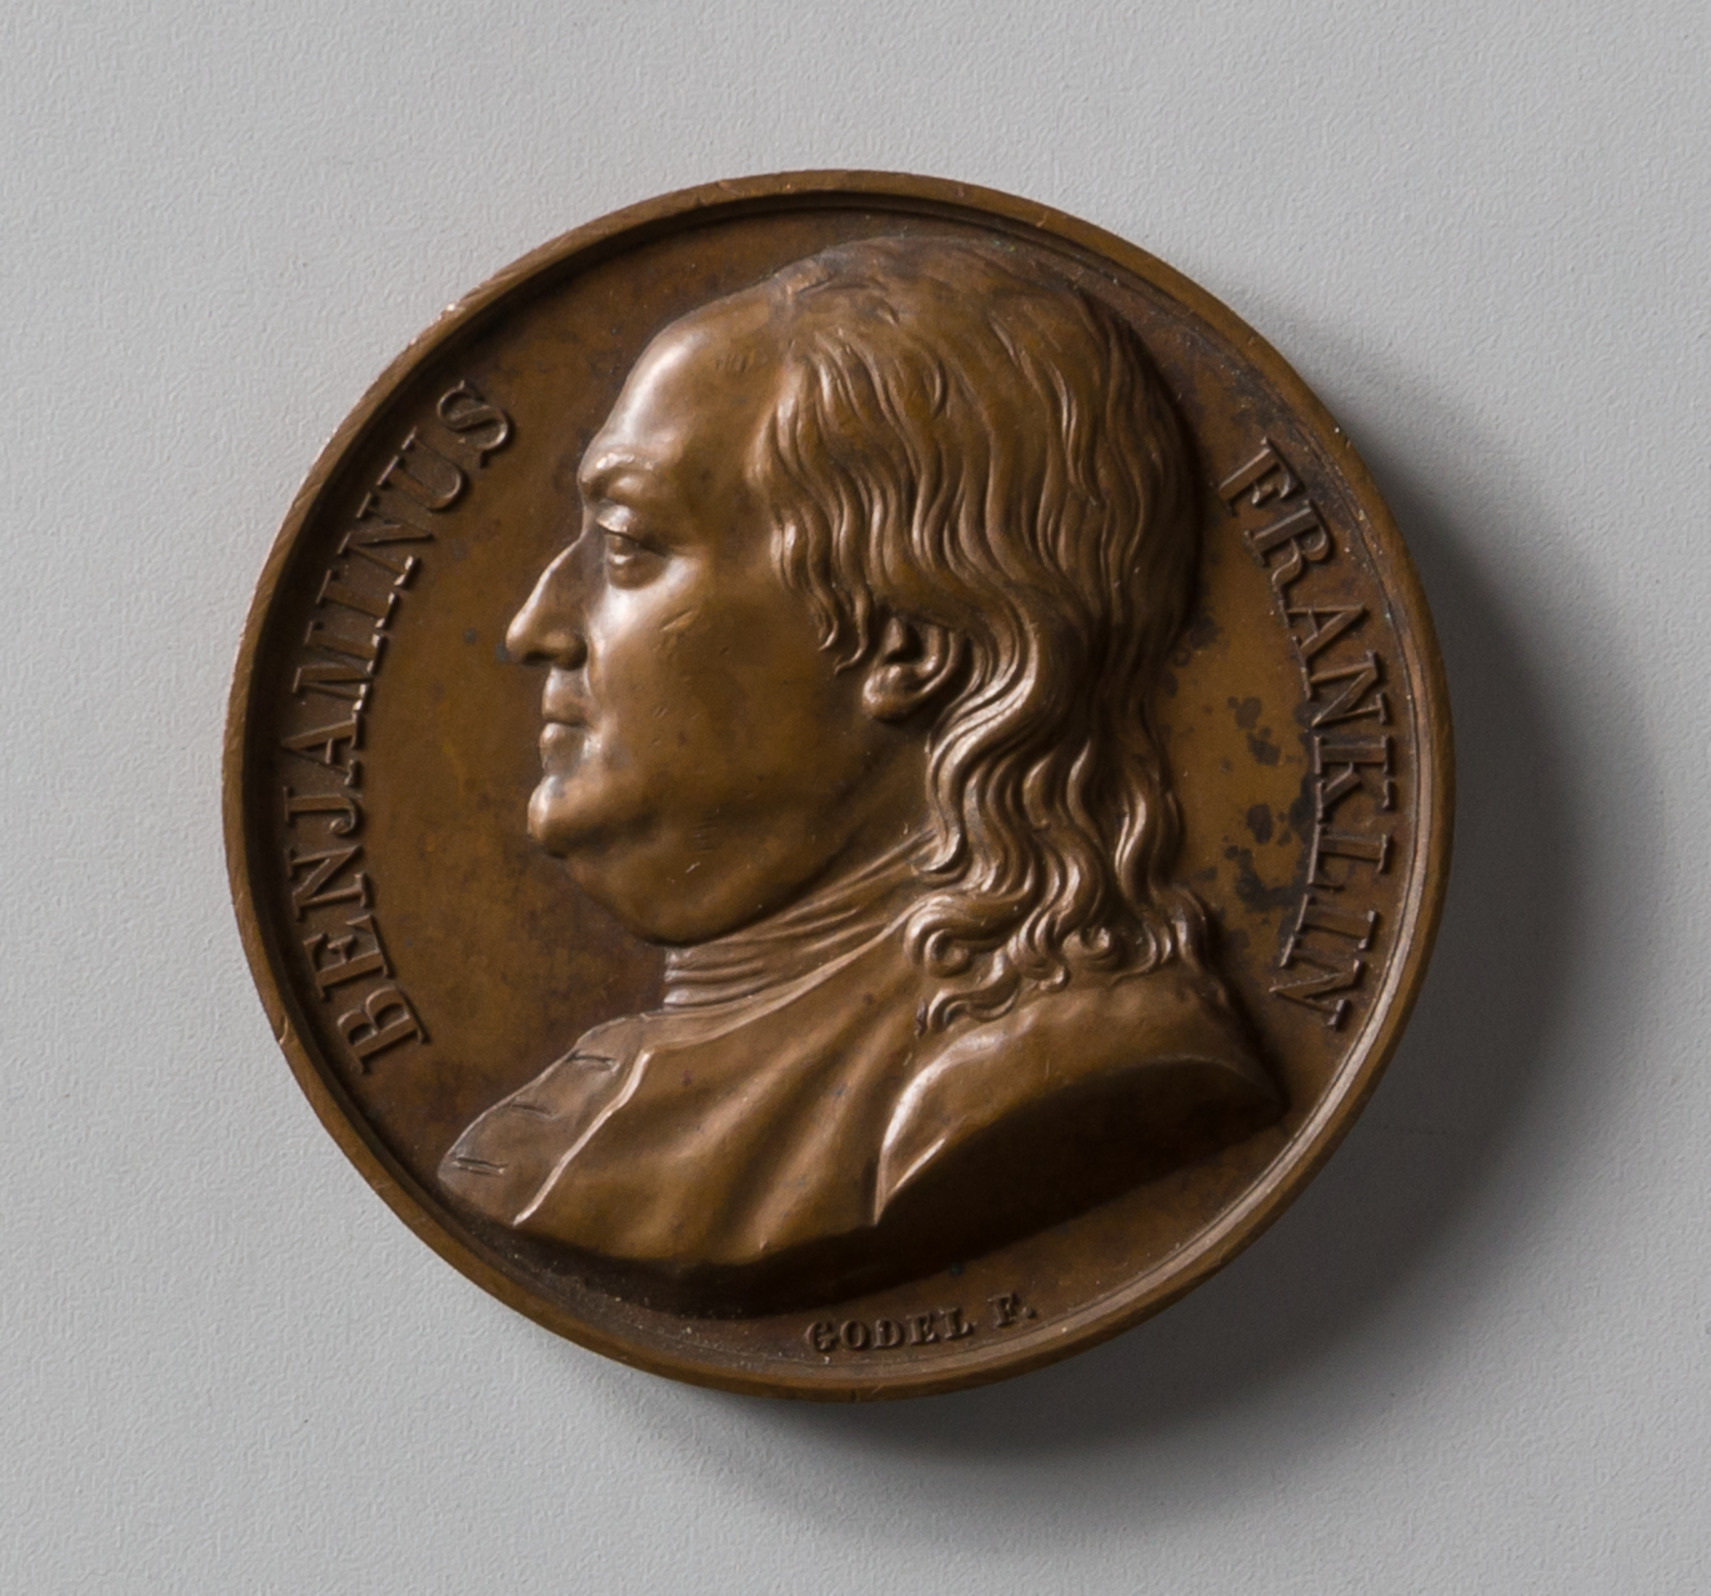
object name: medallion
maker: godel & co. fine art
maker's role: maker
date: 1819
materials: bronze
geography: france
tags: benjamin franklin,profiles